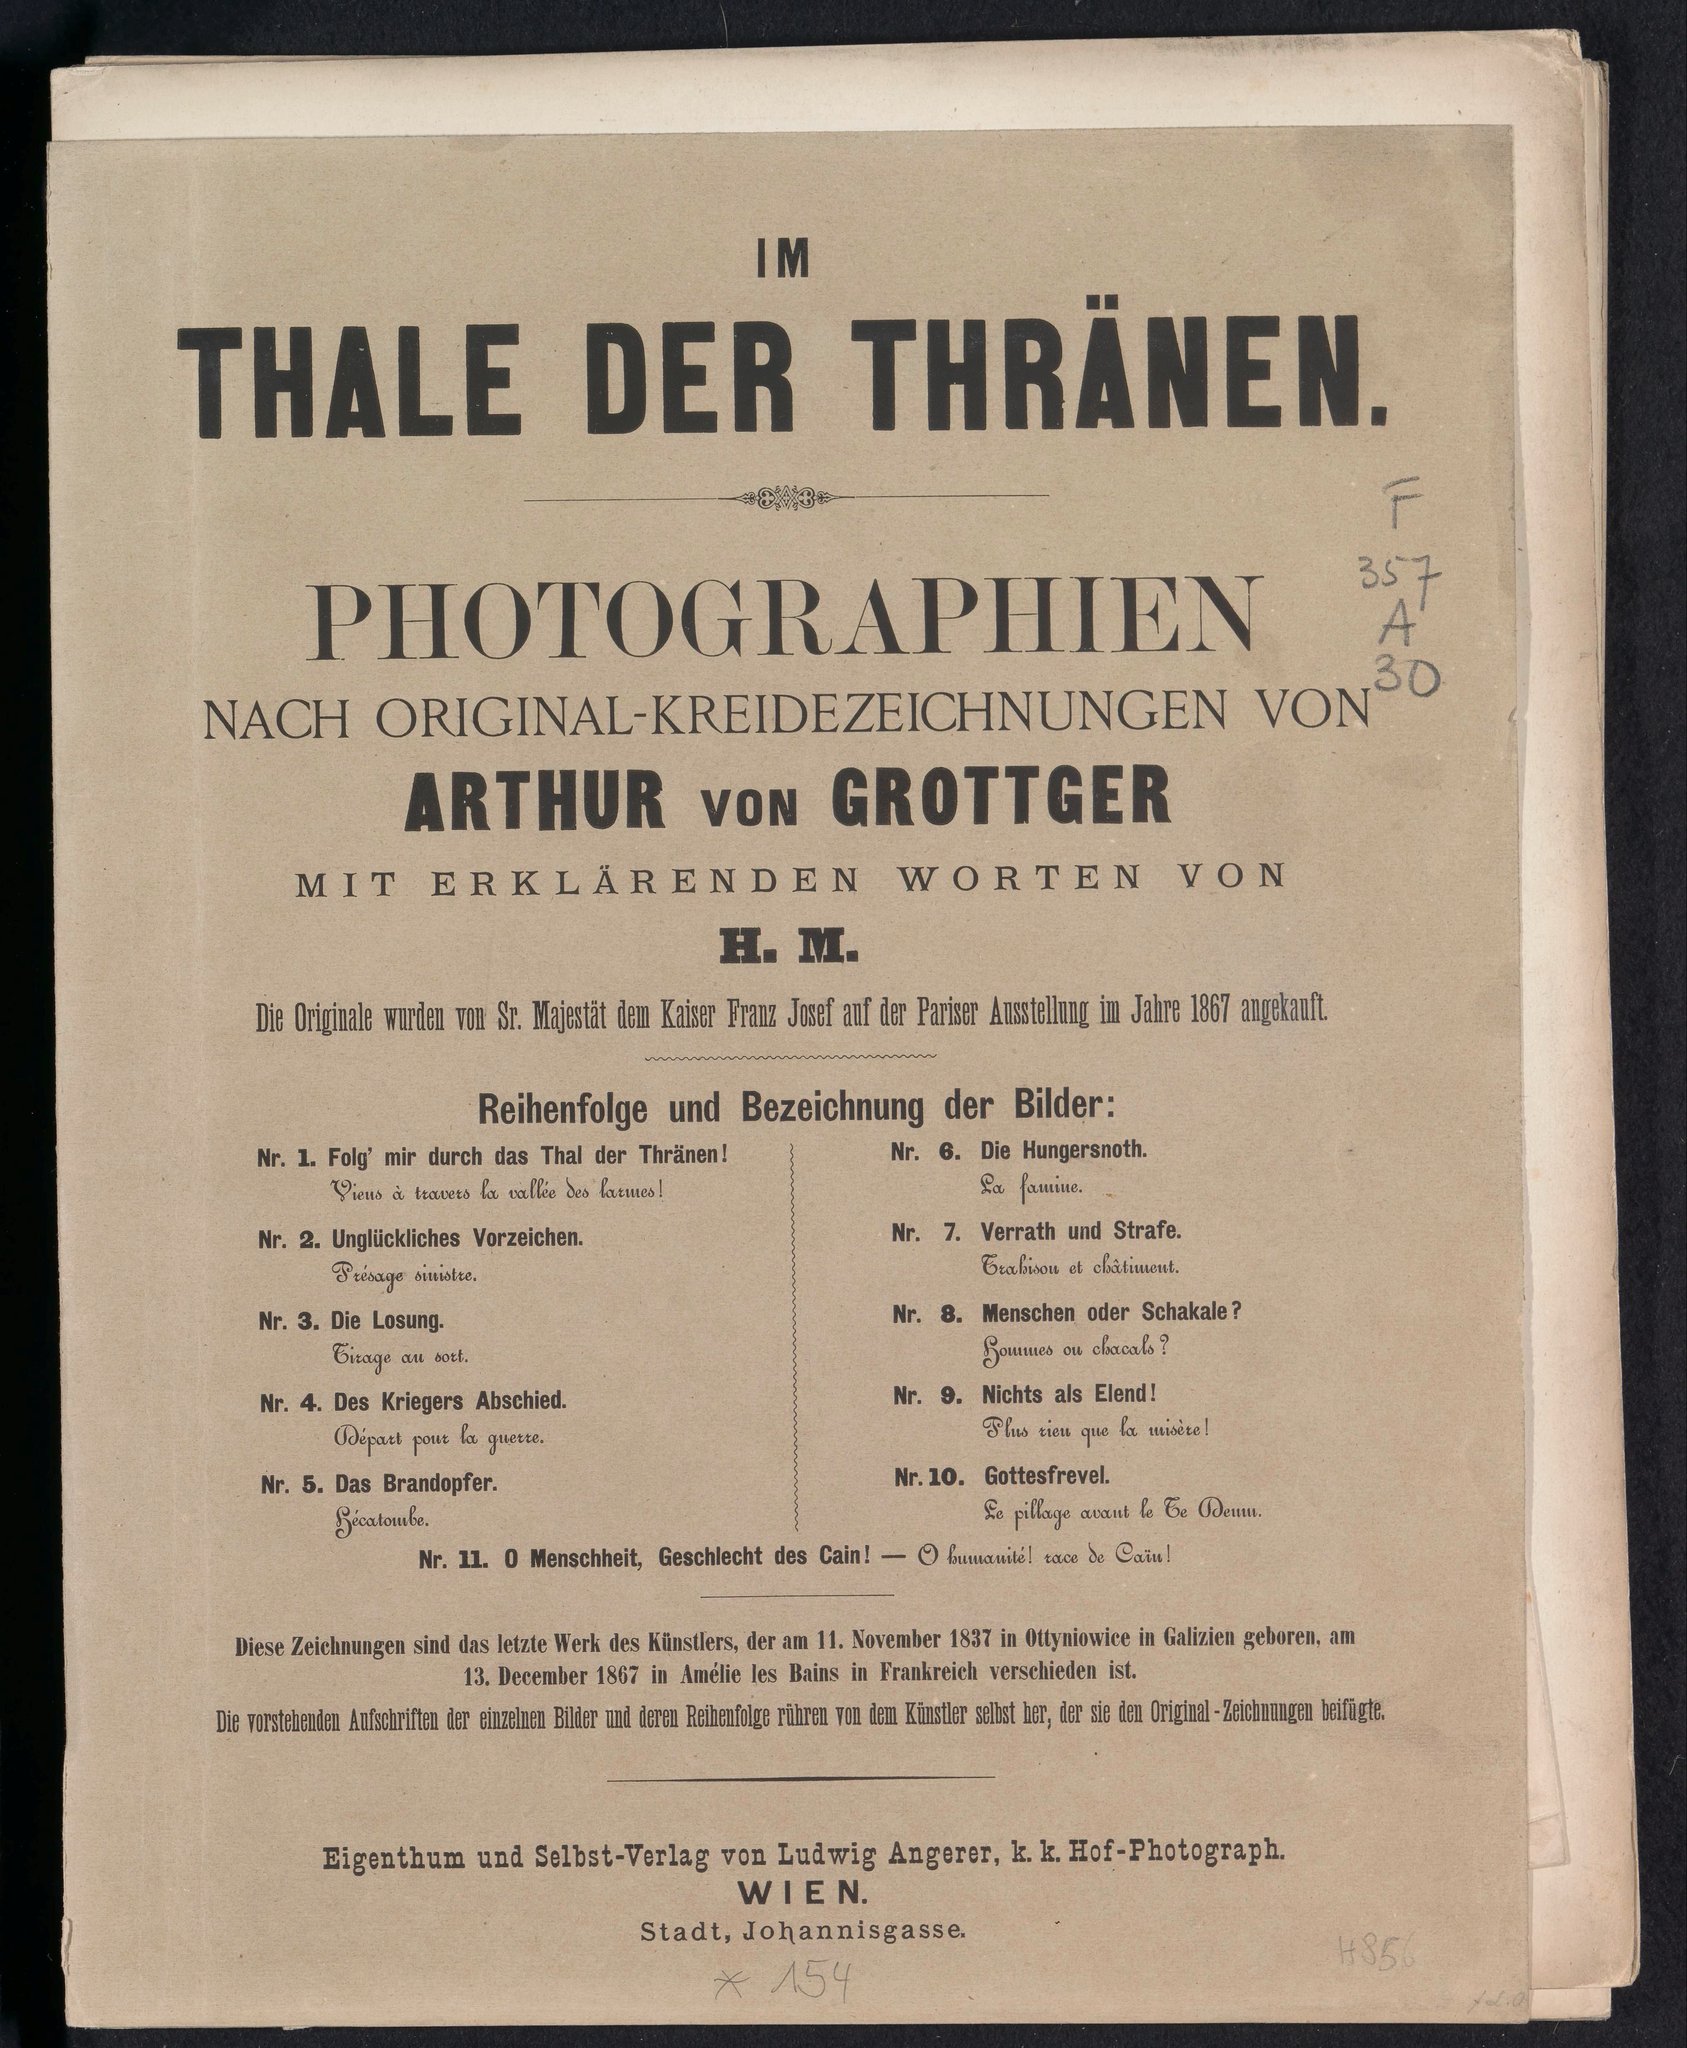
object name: portfolio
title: Im Thale der Tränen : Photographien nach Original-Kreidezeichnungen von Arthur von Grottger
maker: ludwig angerer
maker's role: fotograaf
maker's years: 1827-1879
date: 1868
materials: cardboard, linen, paper, photographic support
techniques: albumen print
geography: vienna